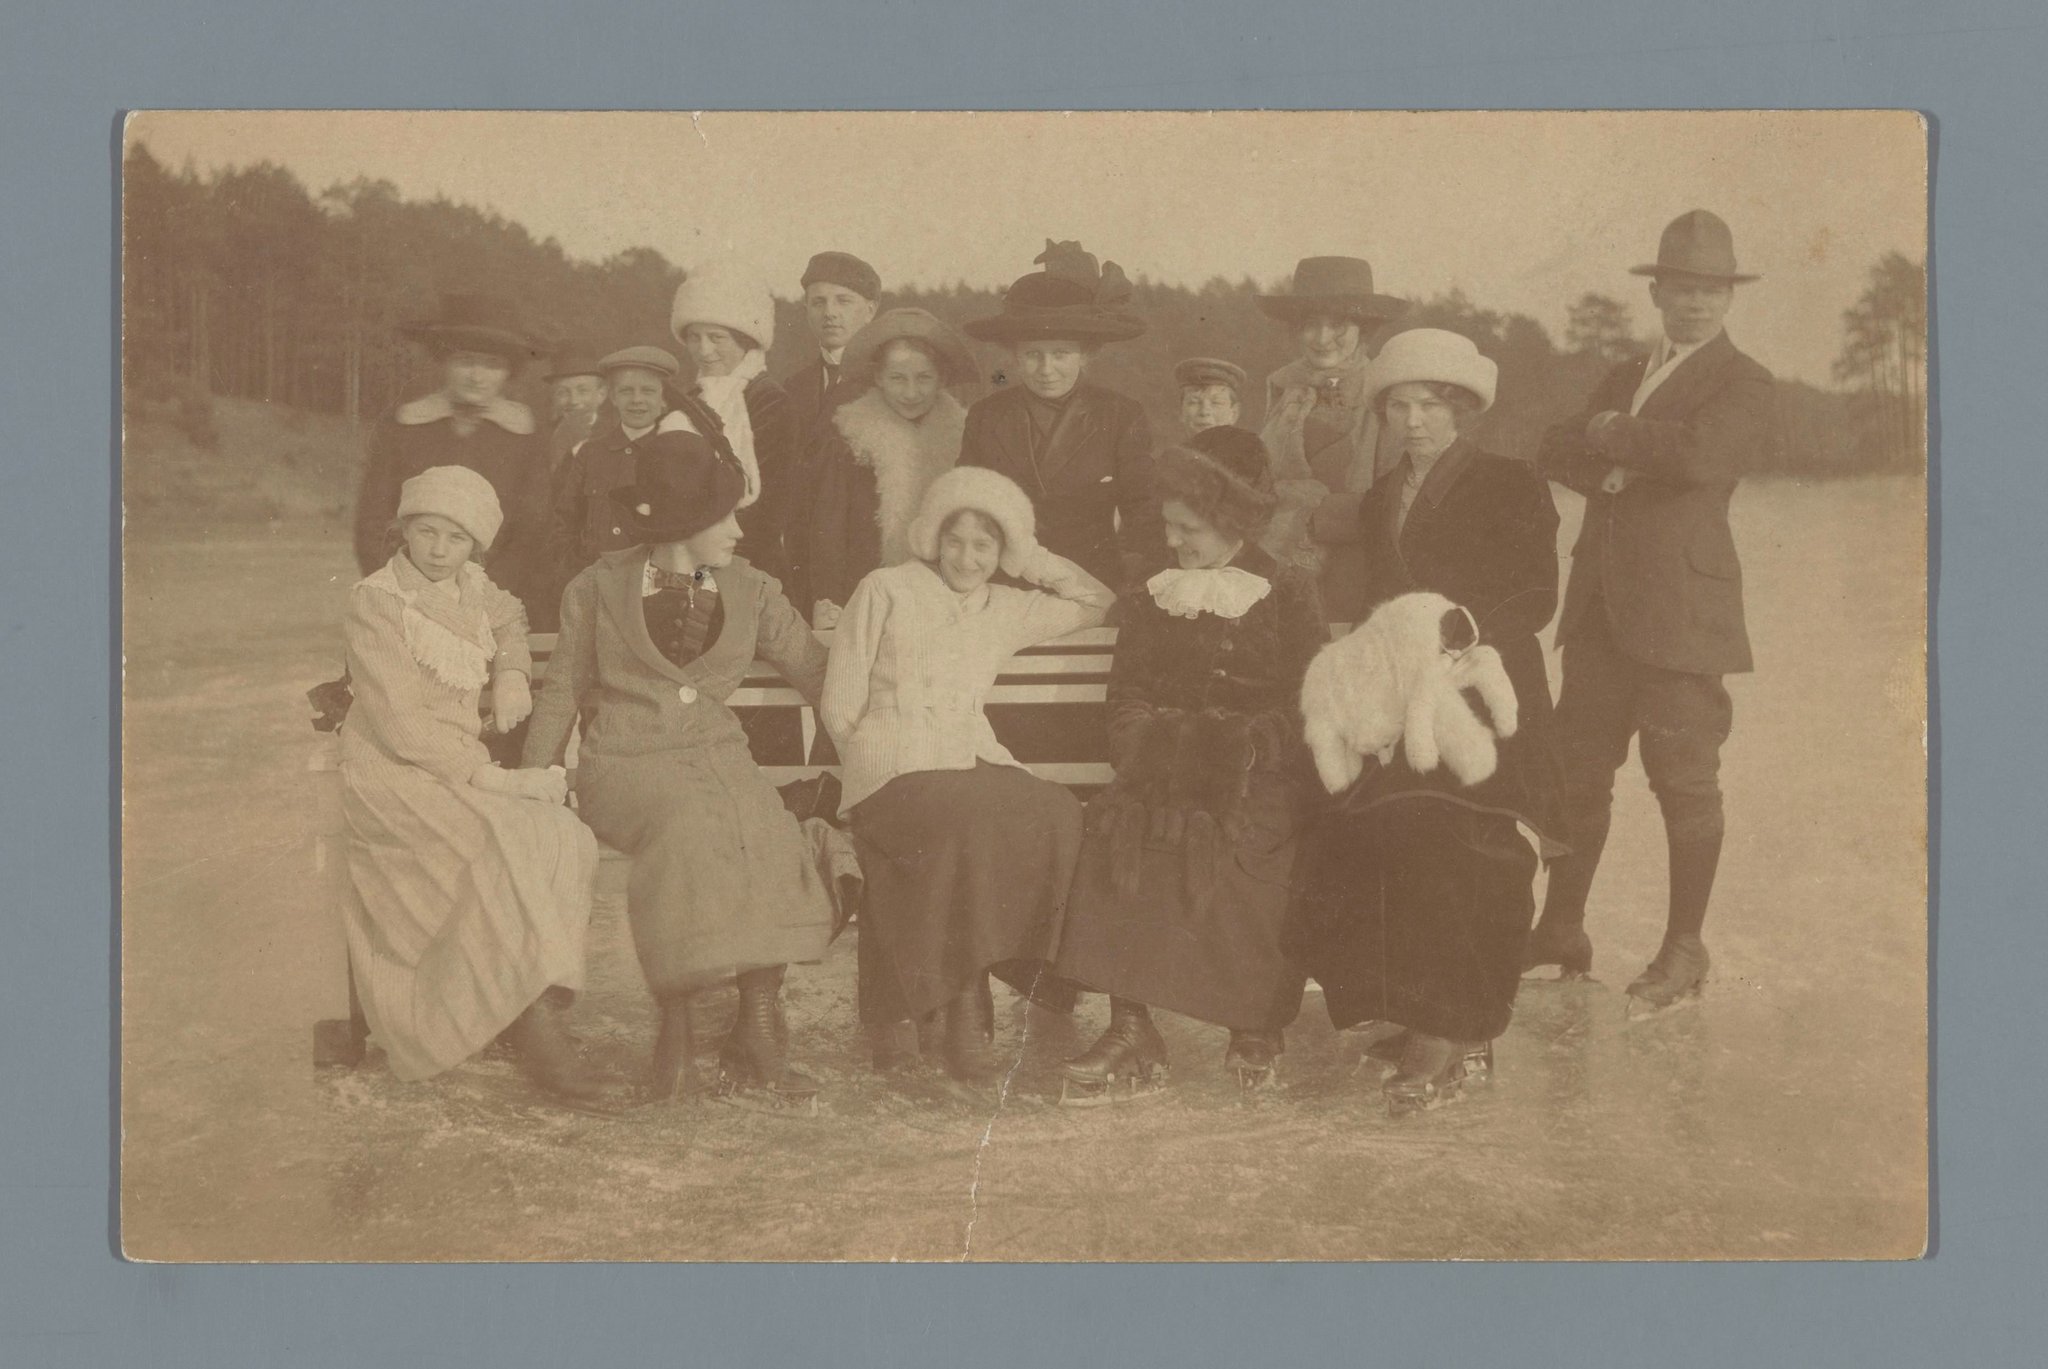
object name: photograph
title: Groepsportret van een onbekend gezelschap op schaatsen op het ijs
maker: Anonymous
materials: photographic support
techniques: gelatin silver print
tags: skates (winter sports), ice ~ state of water, anonymous historical persons portrayed in a group, in a group-portrait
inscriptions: inscription: ‘Winter 1912/13’